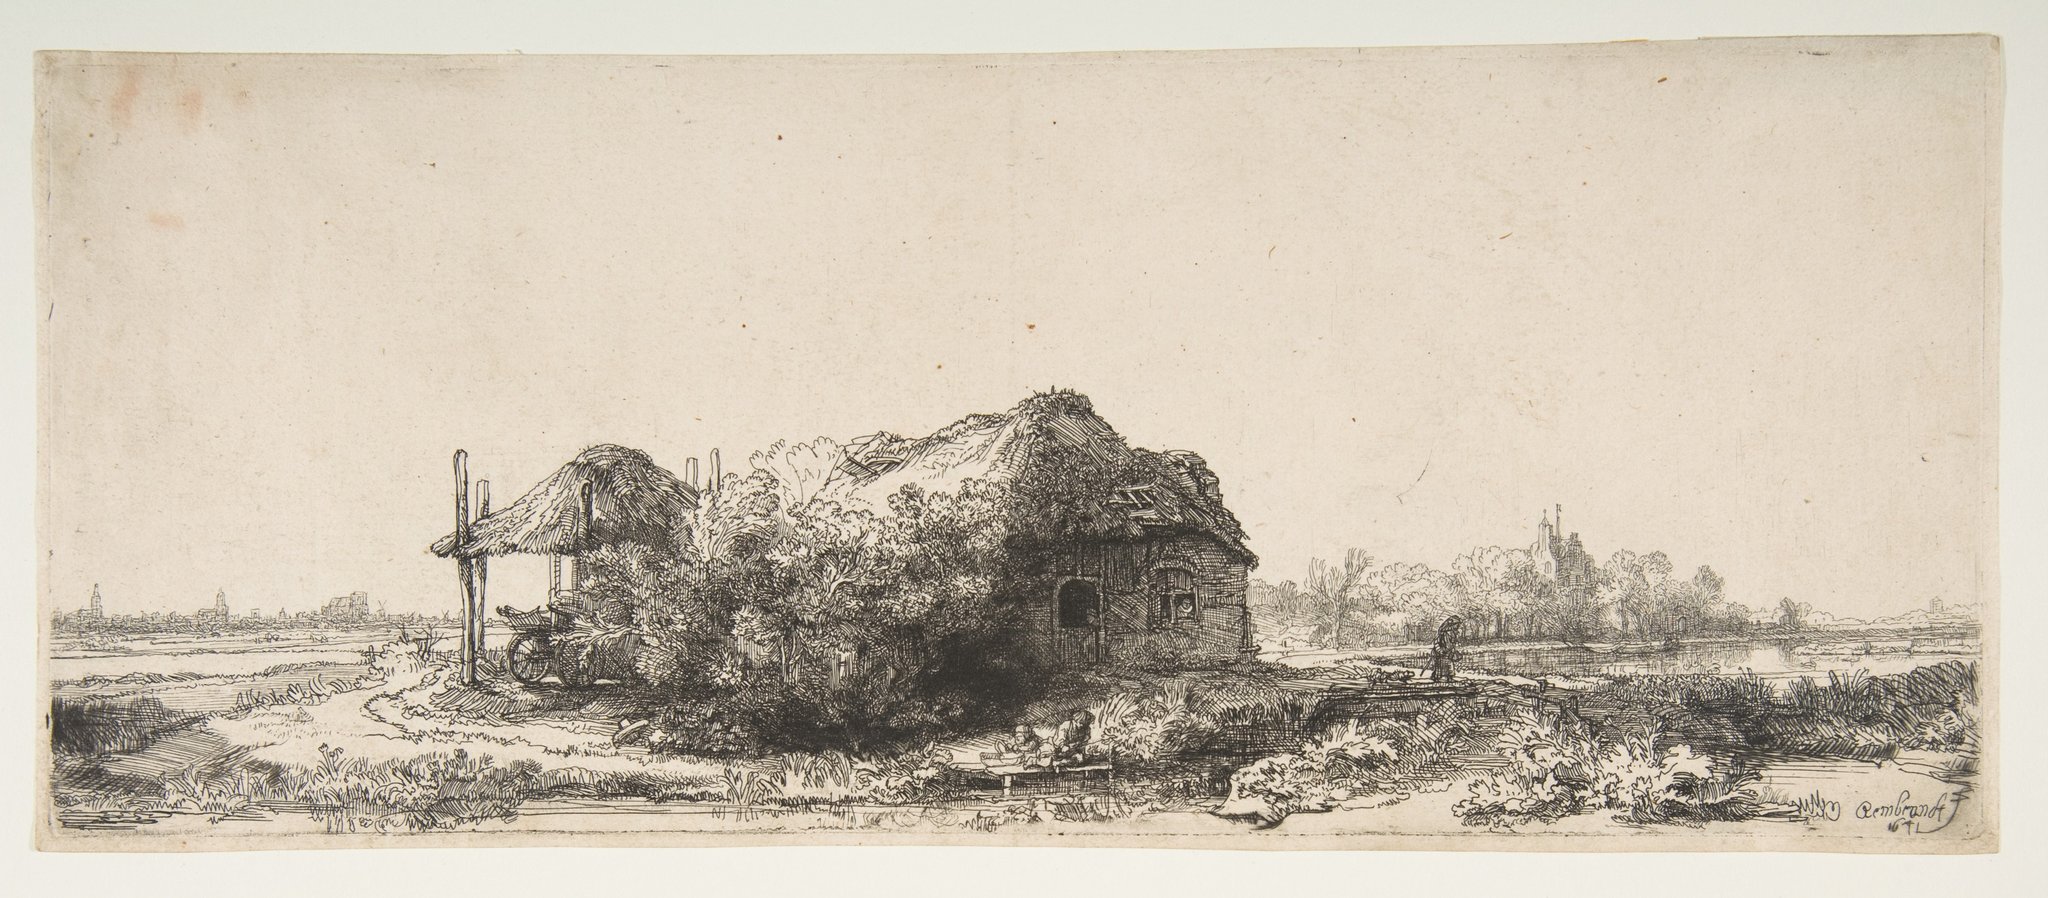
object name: print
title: Landscape with a Cottage and a Haybarn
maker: rembrandt van rijn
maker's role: artist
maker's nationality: dutch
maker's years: 1606-1669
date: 1641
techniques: drypoint, etching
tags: houses,landscapes